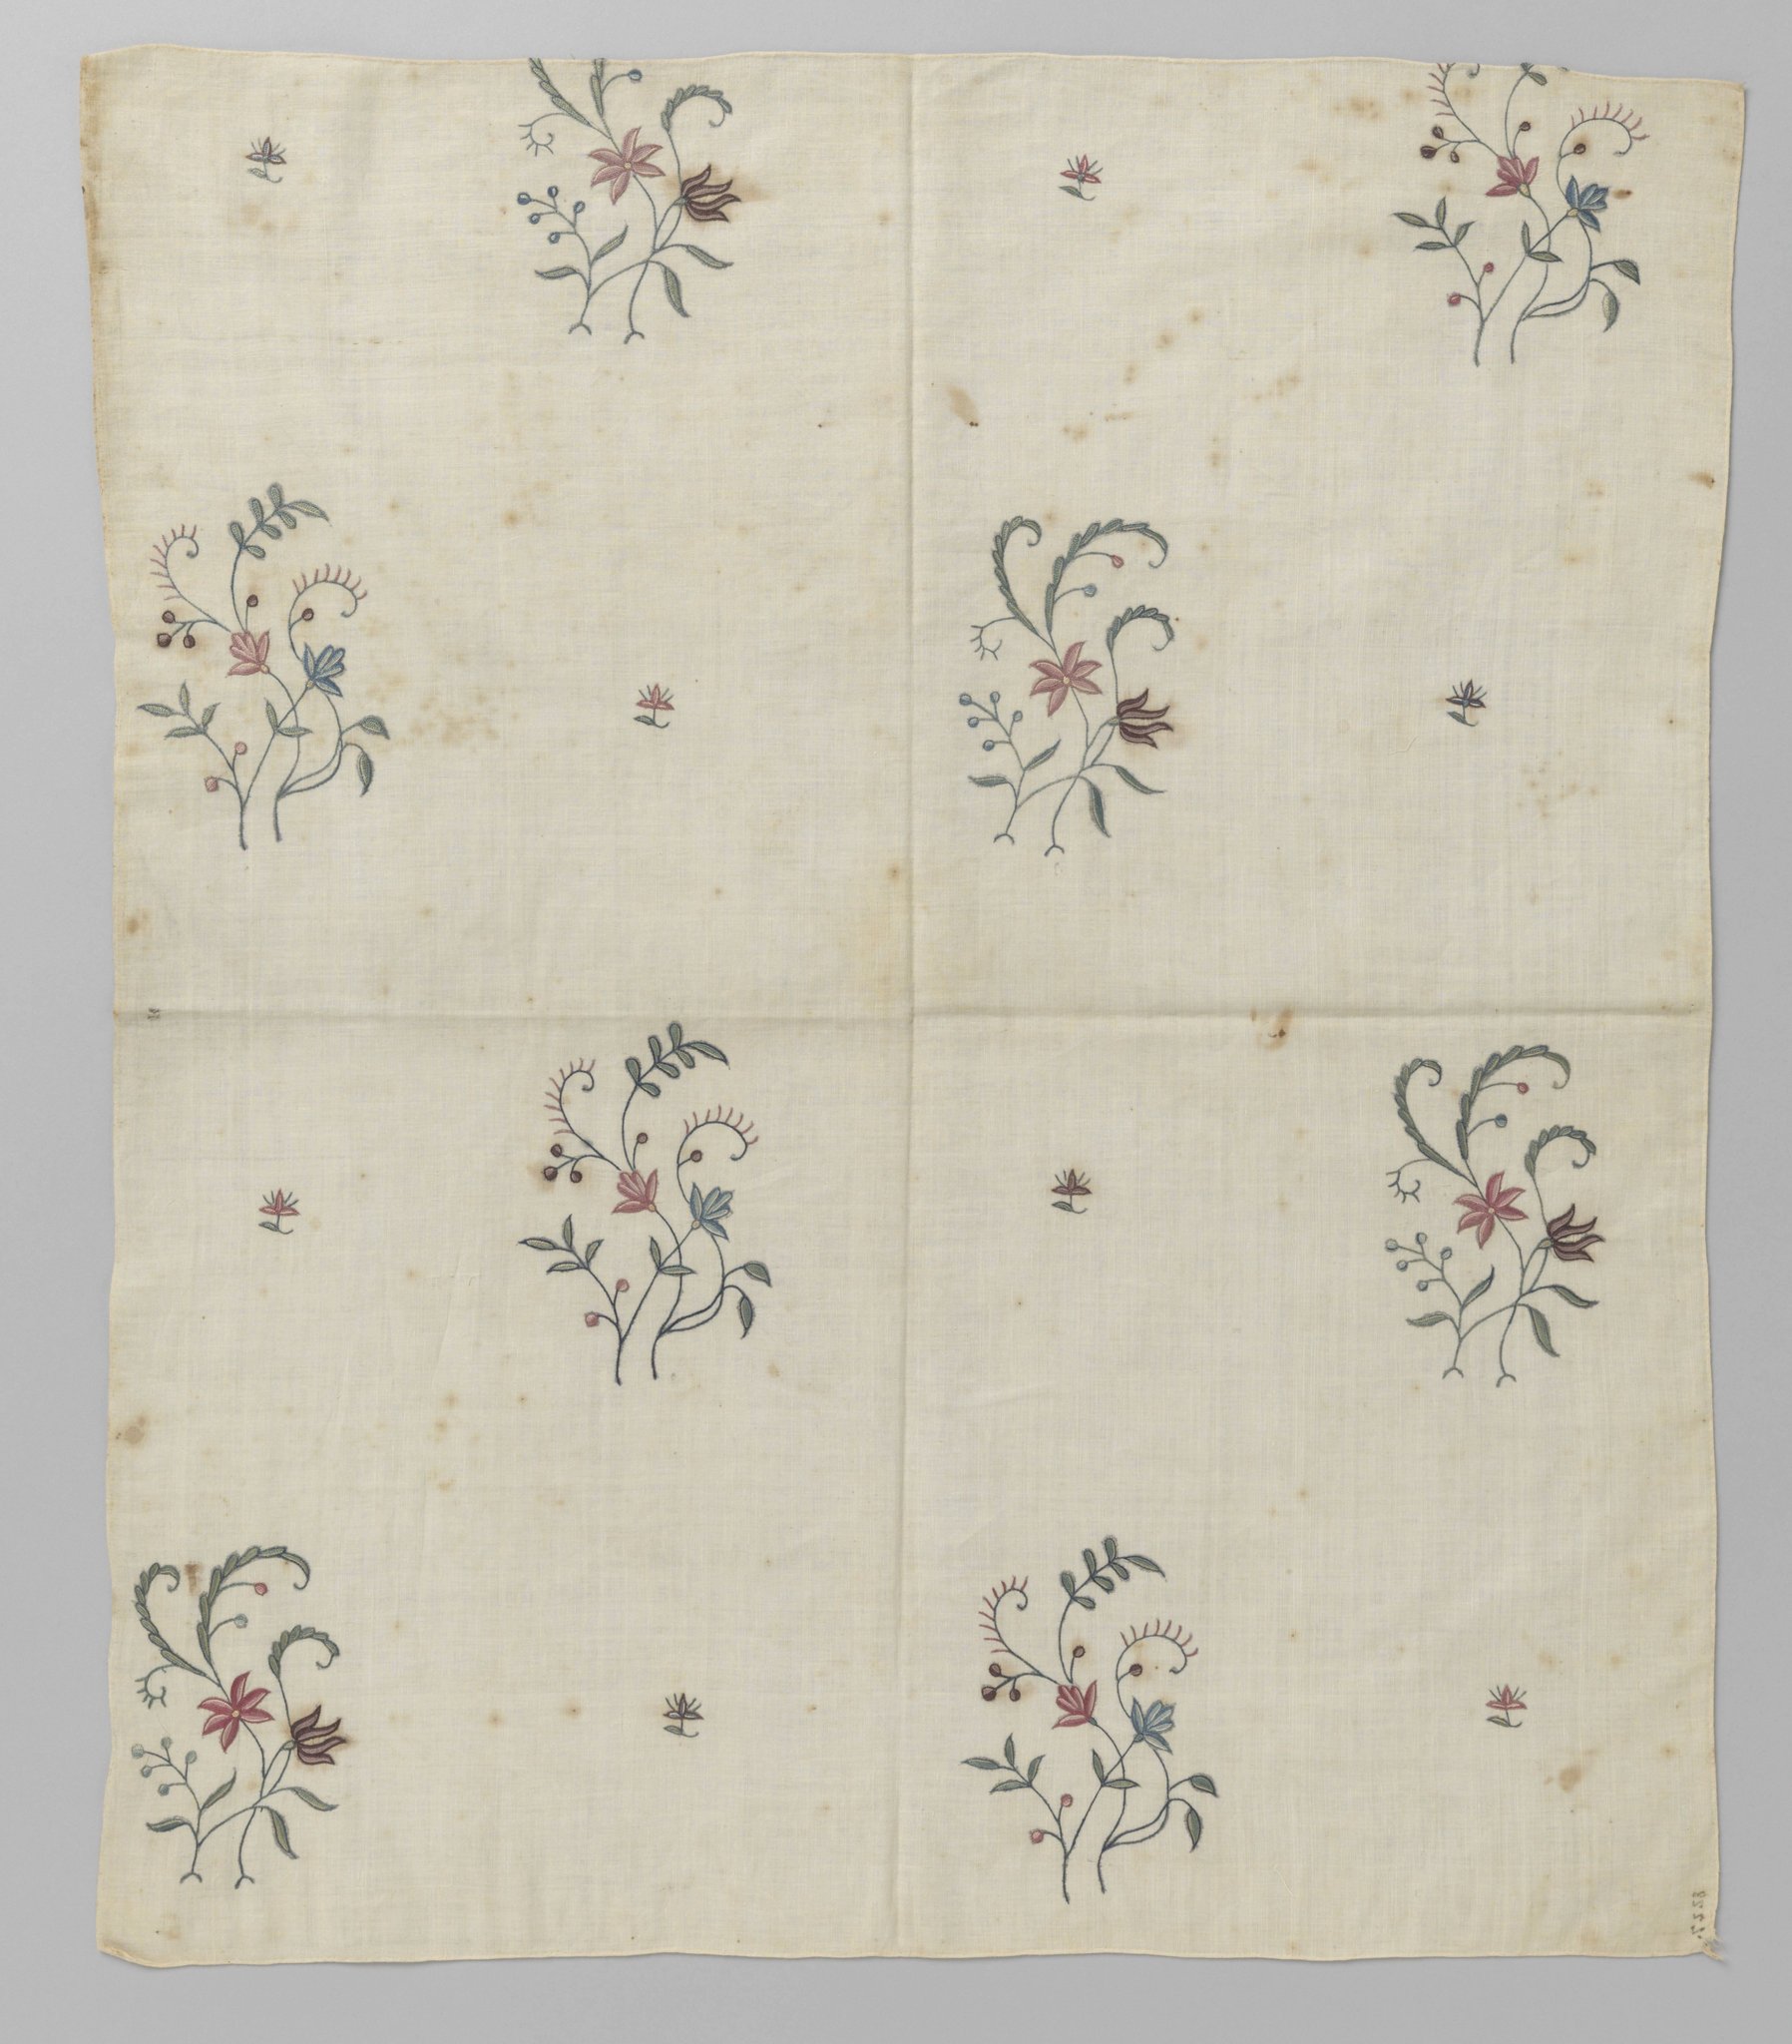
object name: dekkleed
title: Dekkleed van wit katoen, met kleurig zijden borduursel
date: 1700-1800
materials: cotton, silk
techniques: embroidered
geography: iran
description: Dekkleed van wit katoen, met kleurig zijden borduursel. Het patroon heeft verspringende rijen van twee ineengestrengelde fijne gezwenkte takken, waaraan twee bloemen, ranken, bladen en bessen.